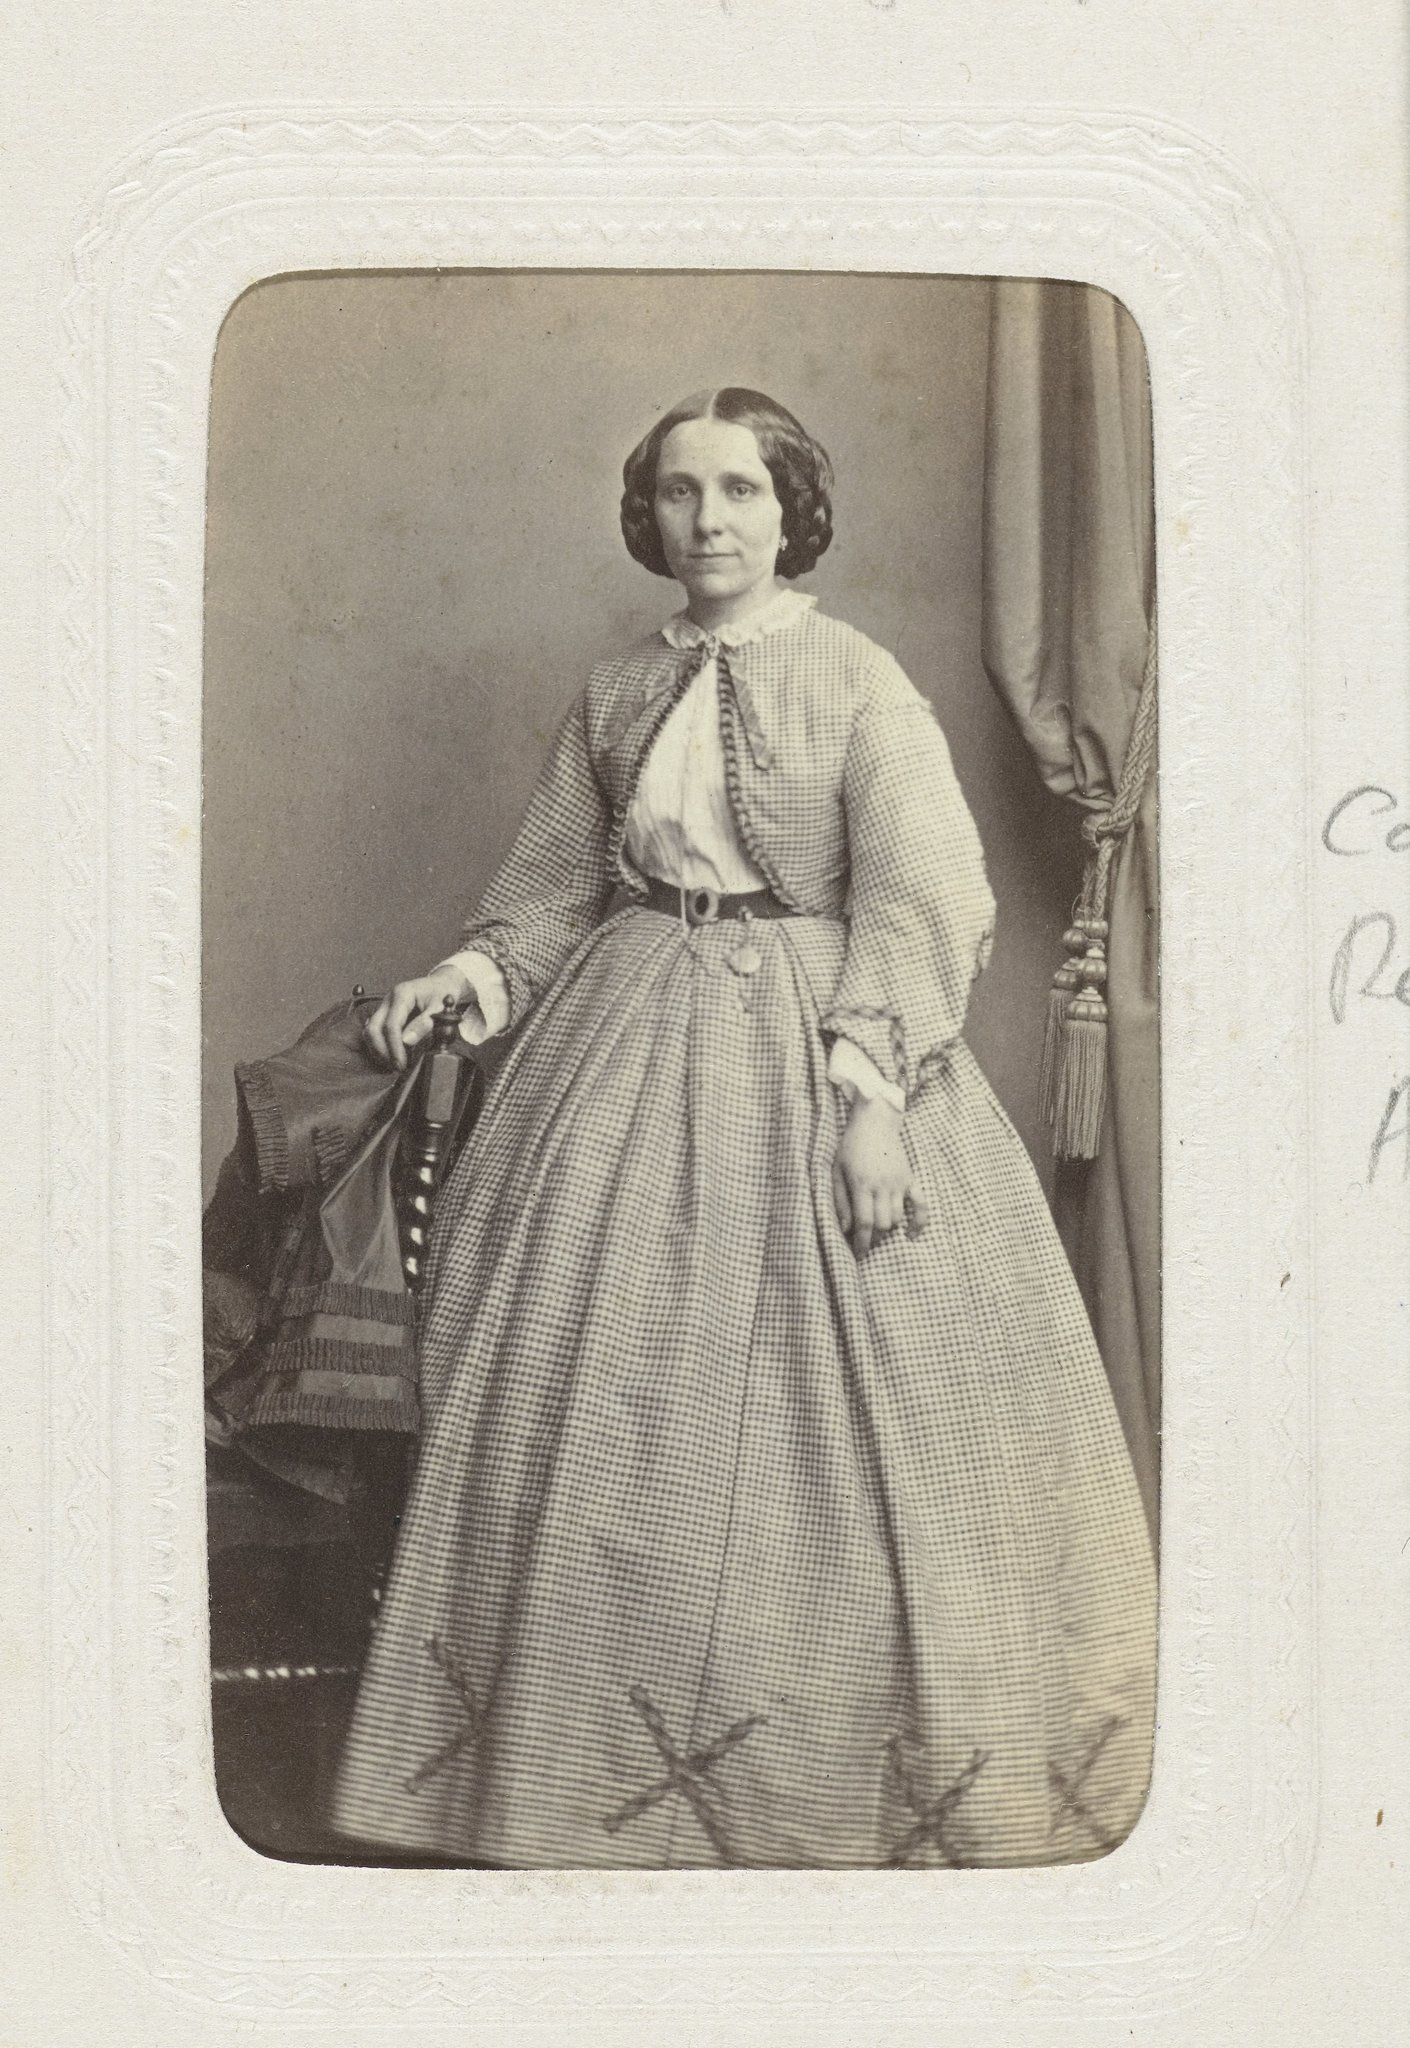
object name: carte de visite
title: Studioportret van een vrouw in een bolle ruitjes rok met bijpassend vest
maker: carl rensing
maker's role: fotograaf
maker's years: 1826-1898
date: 1863-1866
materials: cardboard, paper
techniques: albumen print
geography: amsterdam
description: Op de foto zijn dezelfde meubels te zien als bij foto nr 37,38,39 en 40